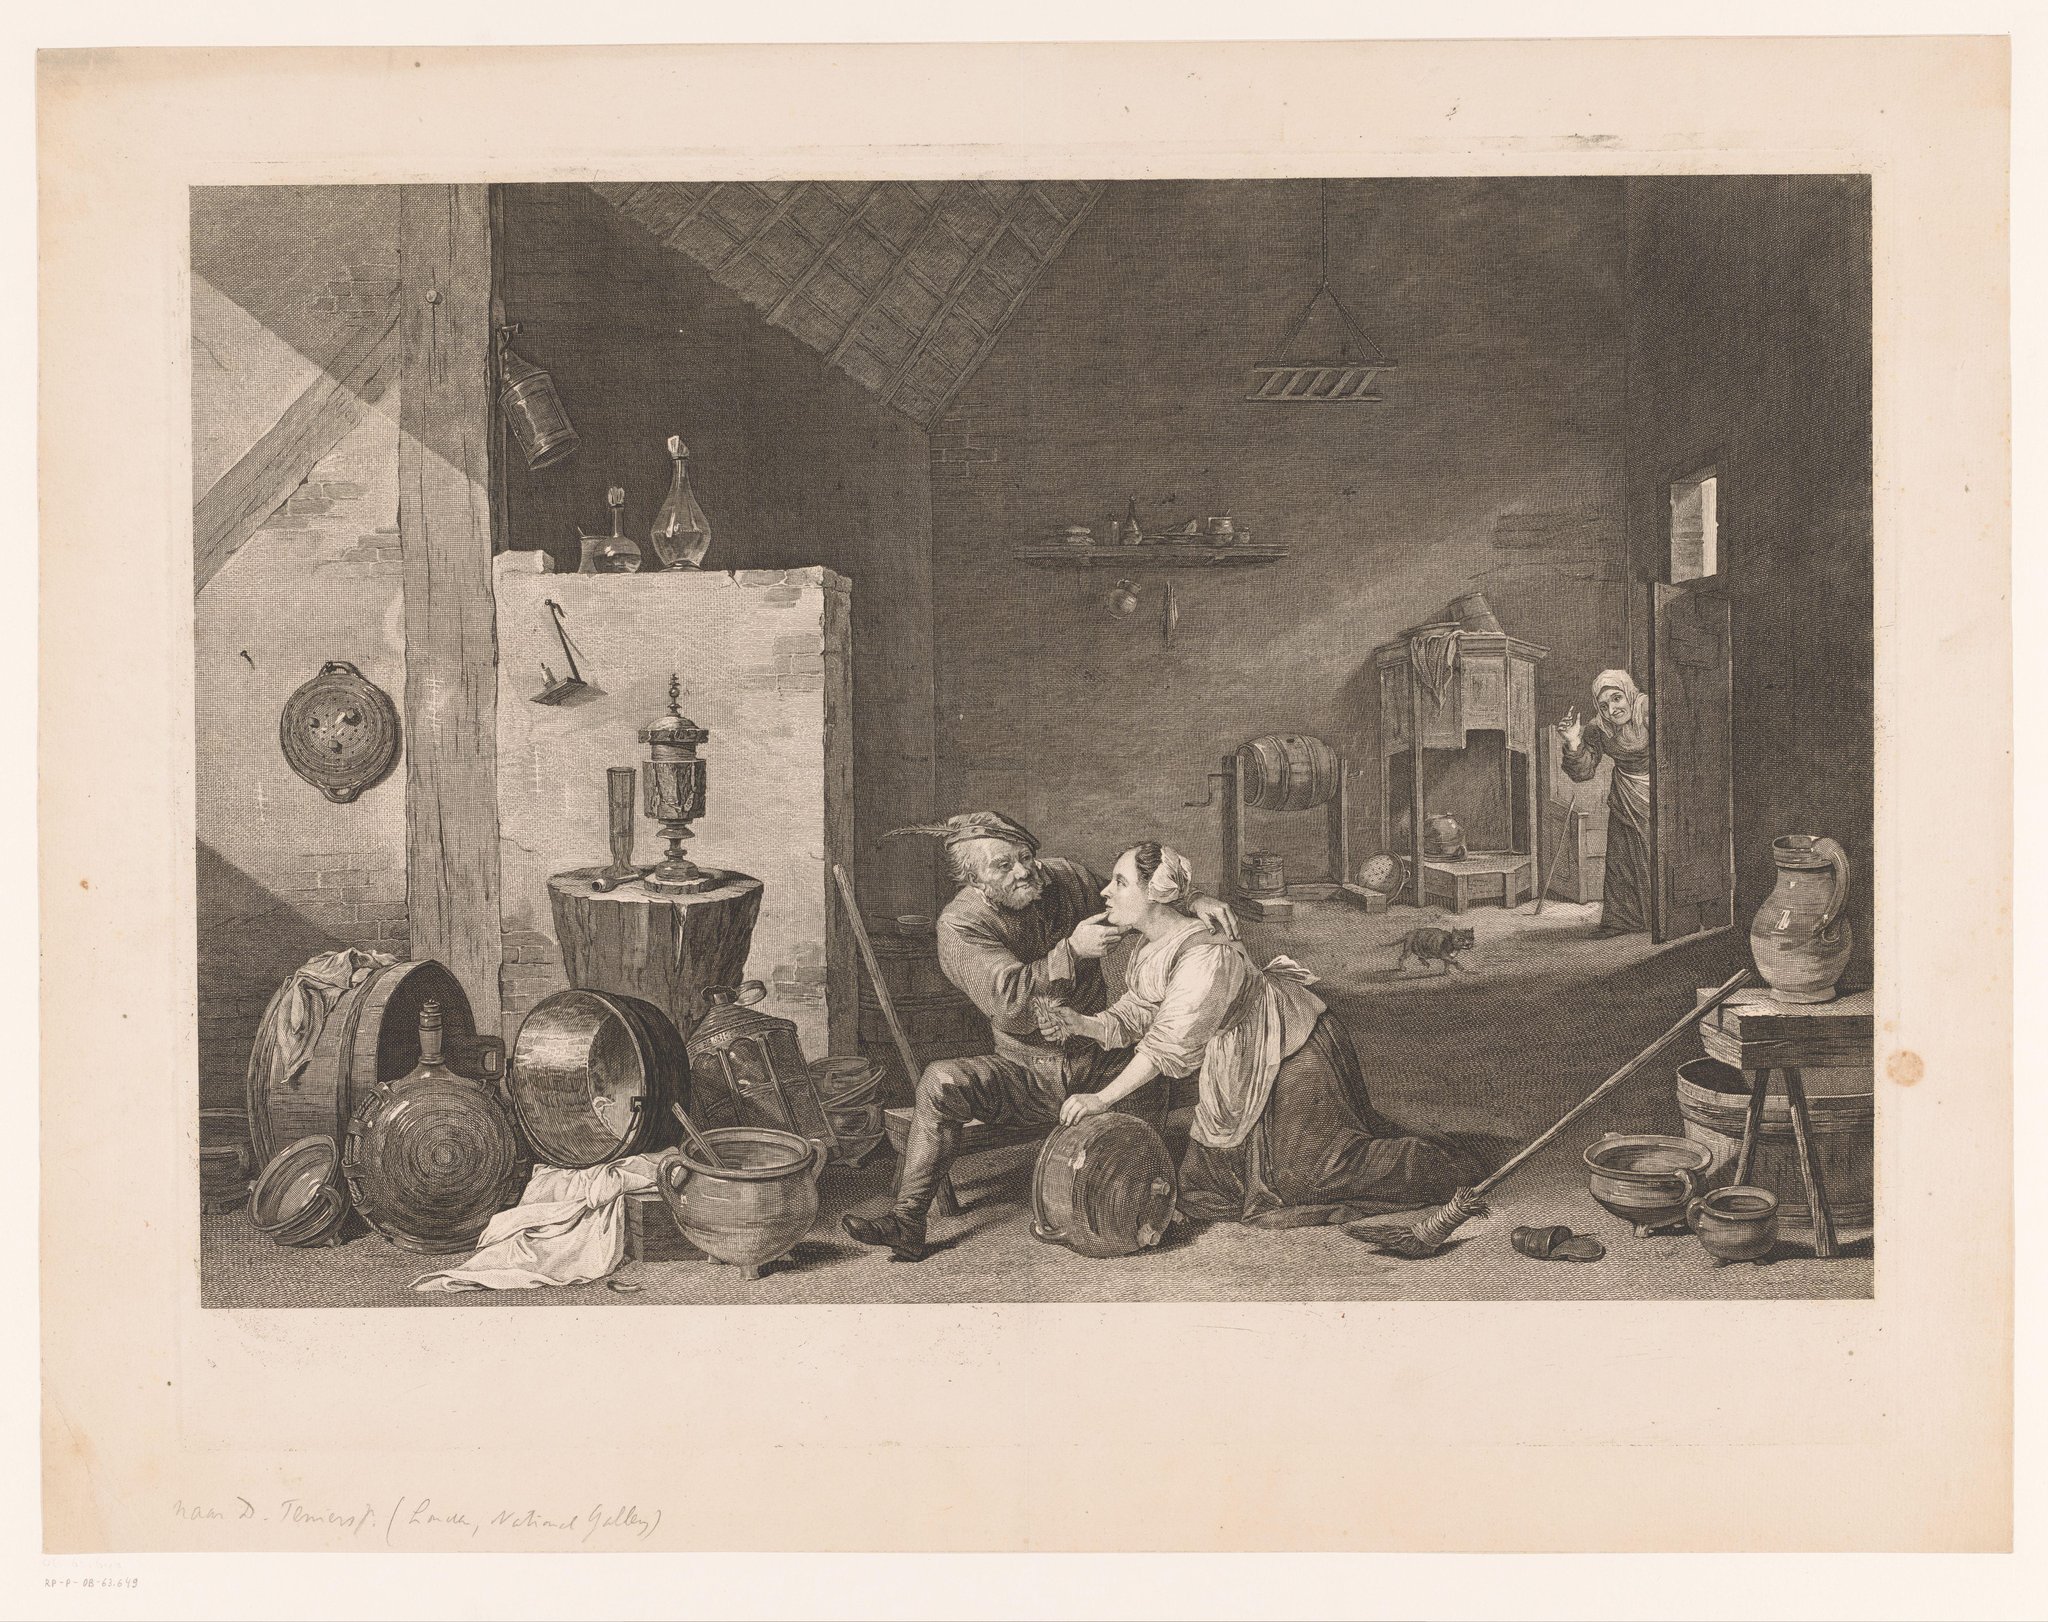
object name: print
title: Interieur met man die wordt betrapt door zijn vrouw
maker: Anonymous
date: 1600-1699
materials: paper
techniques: engraving, etching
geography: france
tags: betrayal (+ situation or event (especially in genre-painting) with symbolical connotation), unsuccessful love affair; seduction, interior of the house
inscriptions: collector's mark: Lugt 240